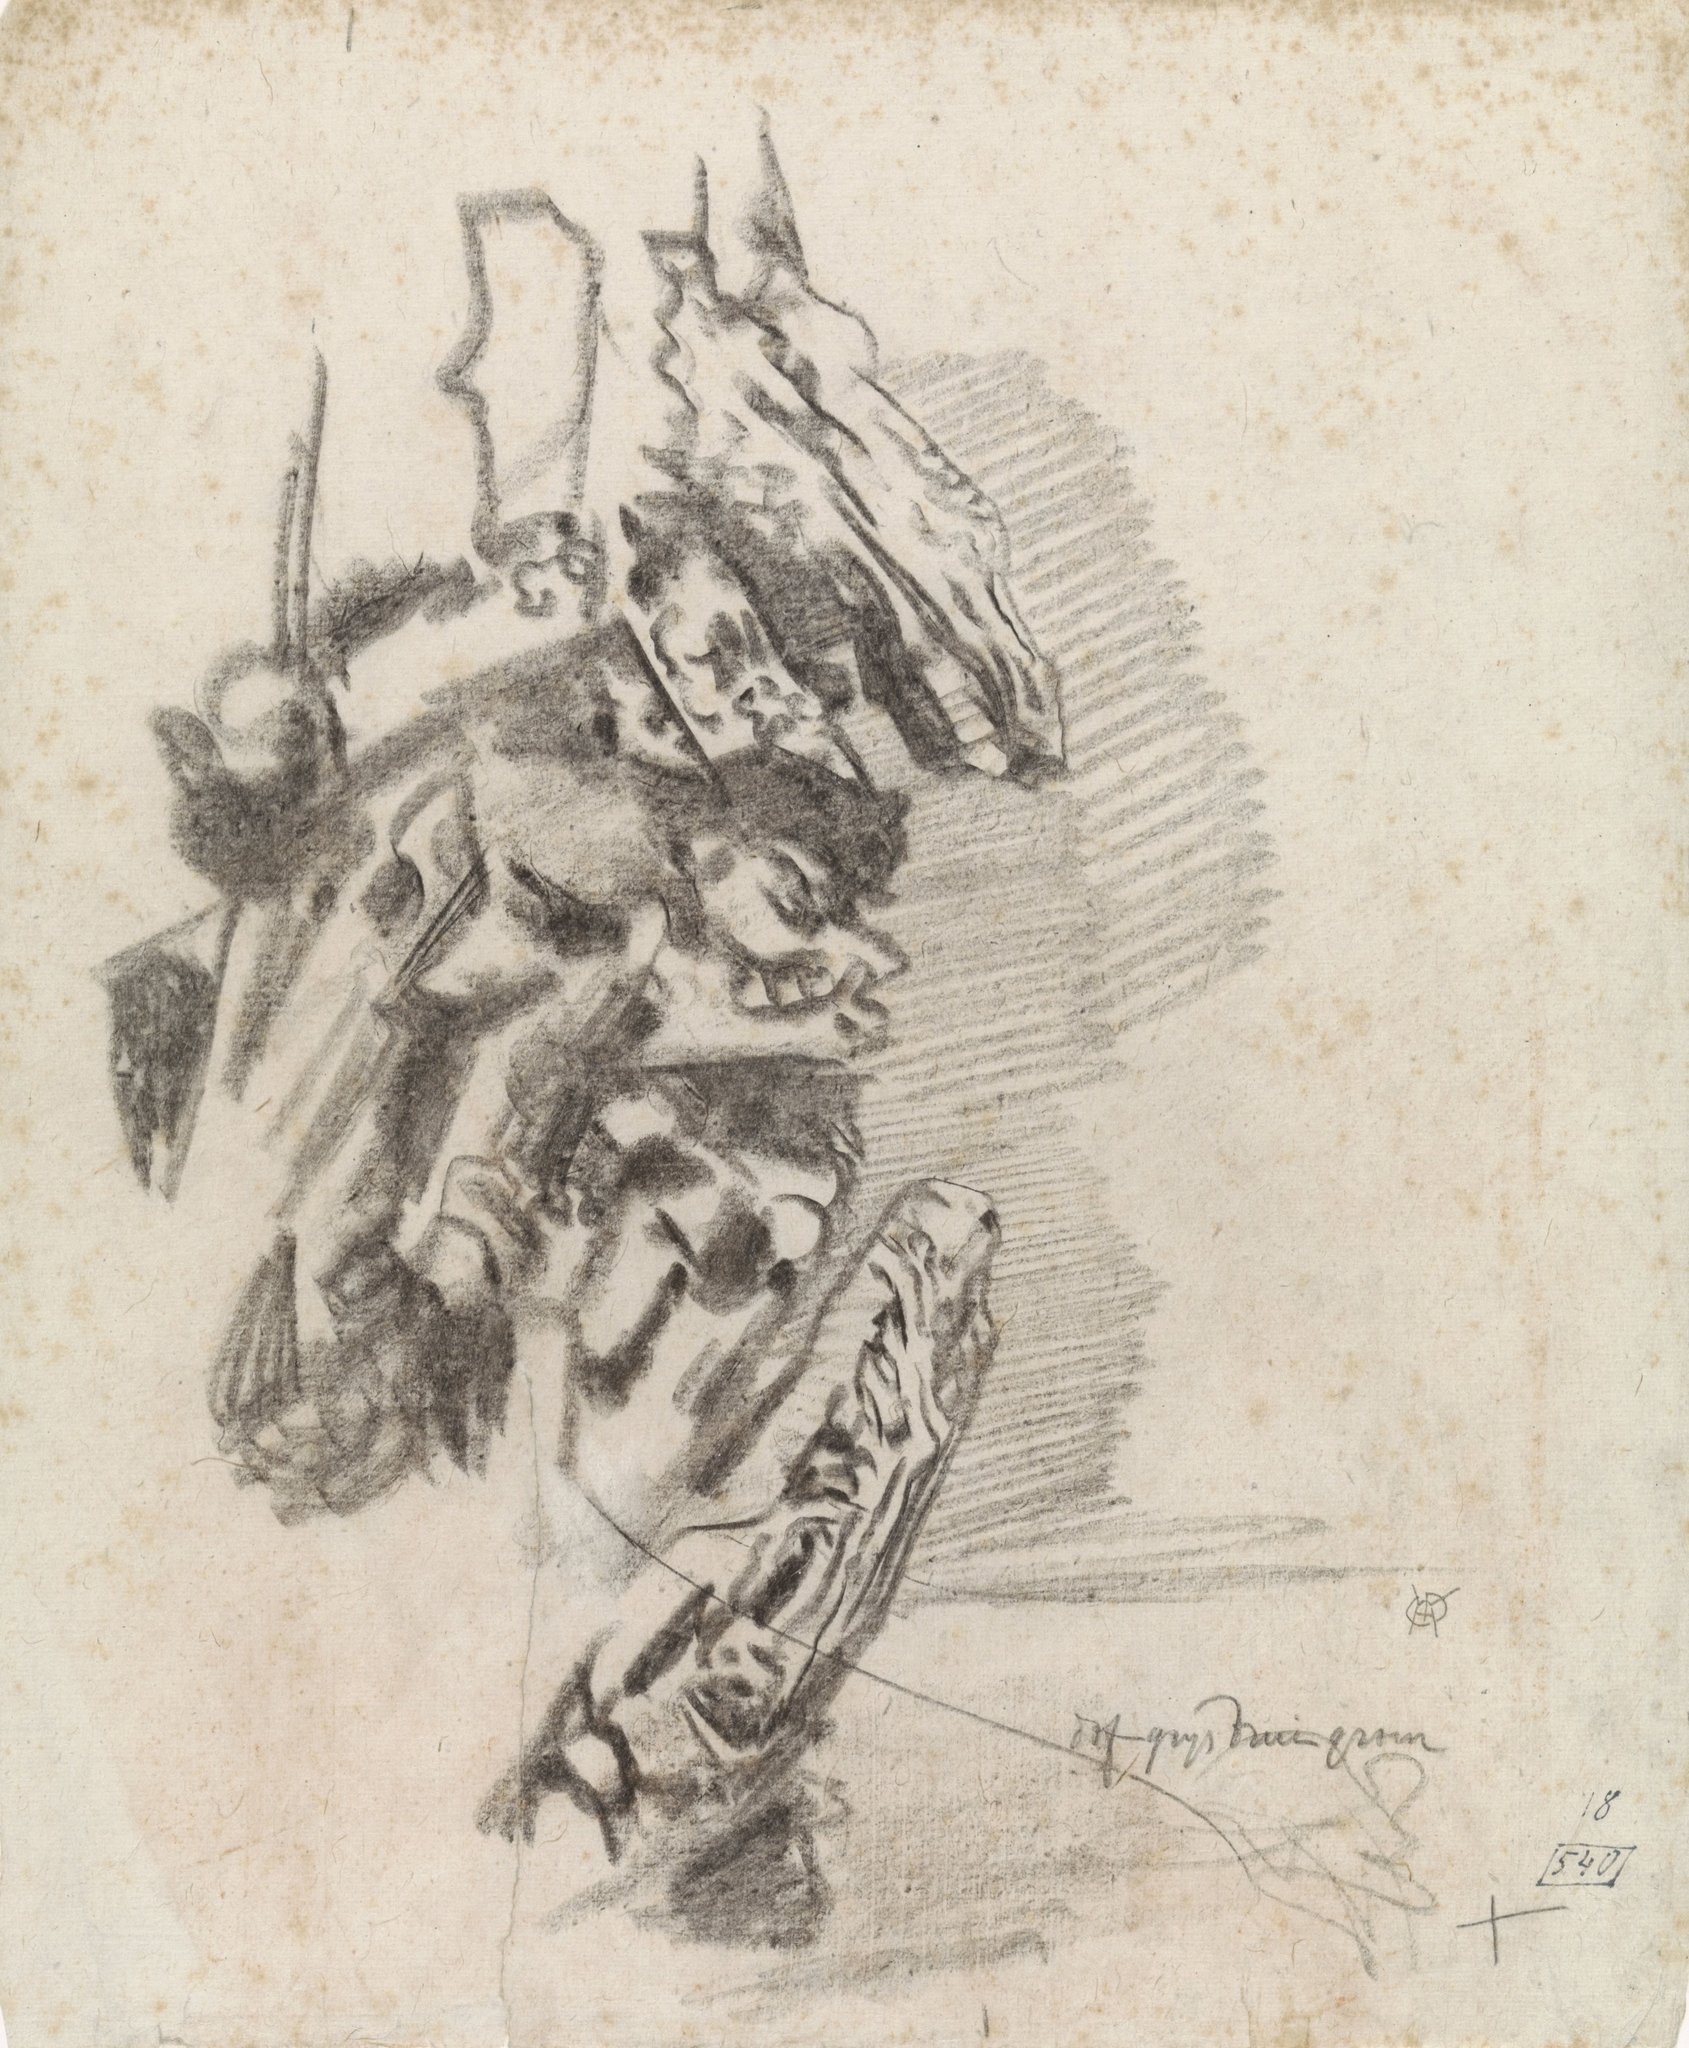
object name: drawing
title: Rotspartij in een aquarium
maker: gerrit willem dijsselhof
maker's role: designer, draughtsman, print maker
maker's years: 1866-1924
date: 1876-1924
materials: chalk, paper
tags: aquarium